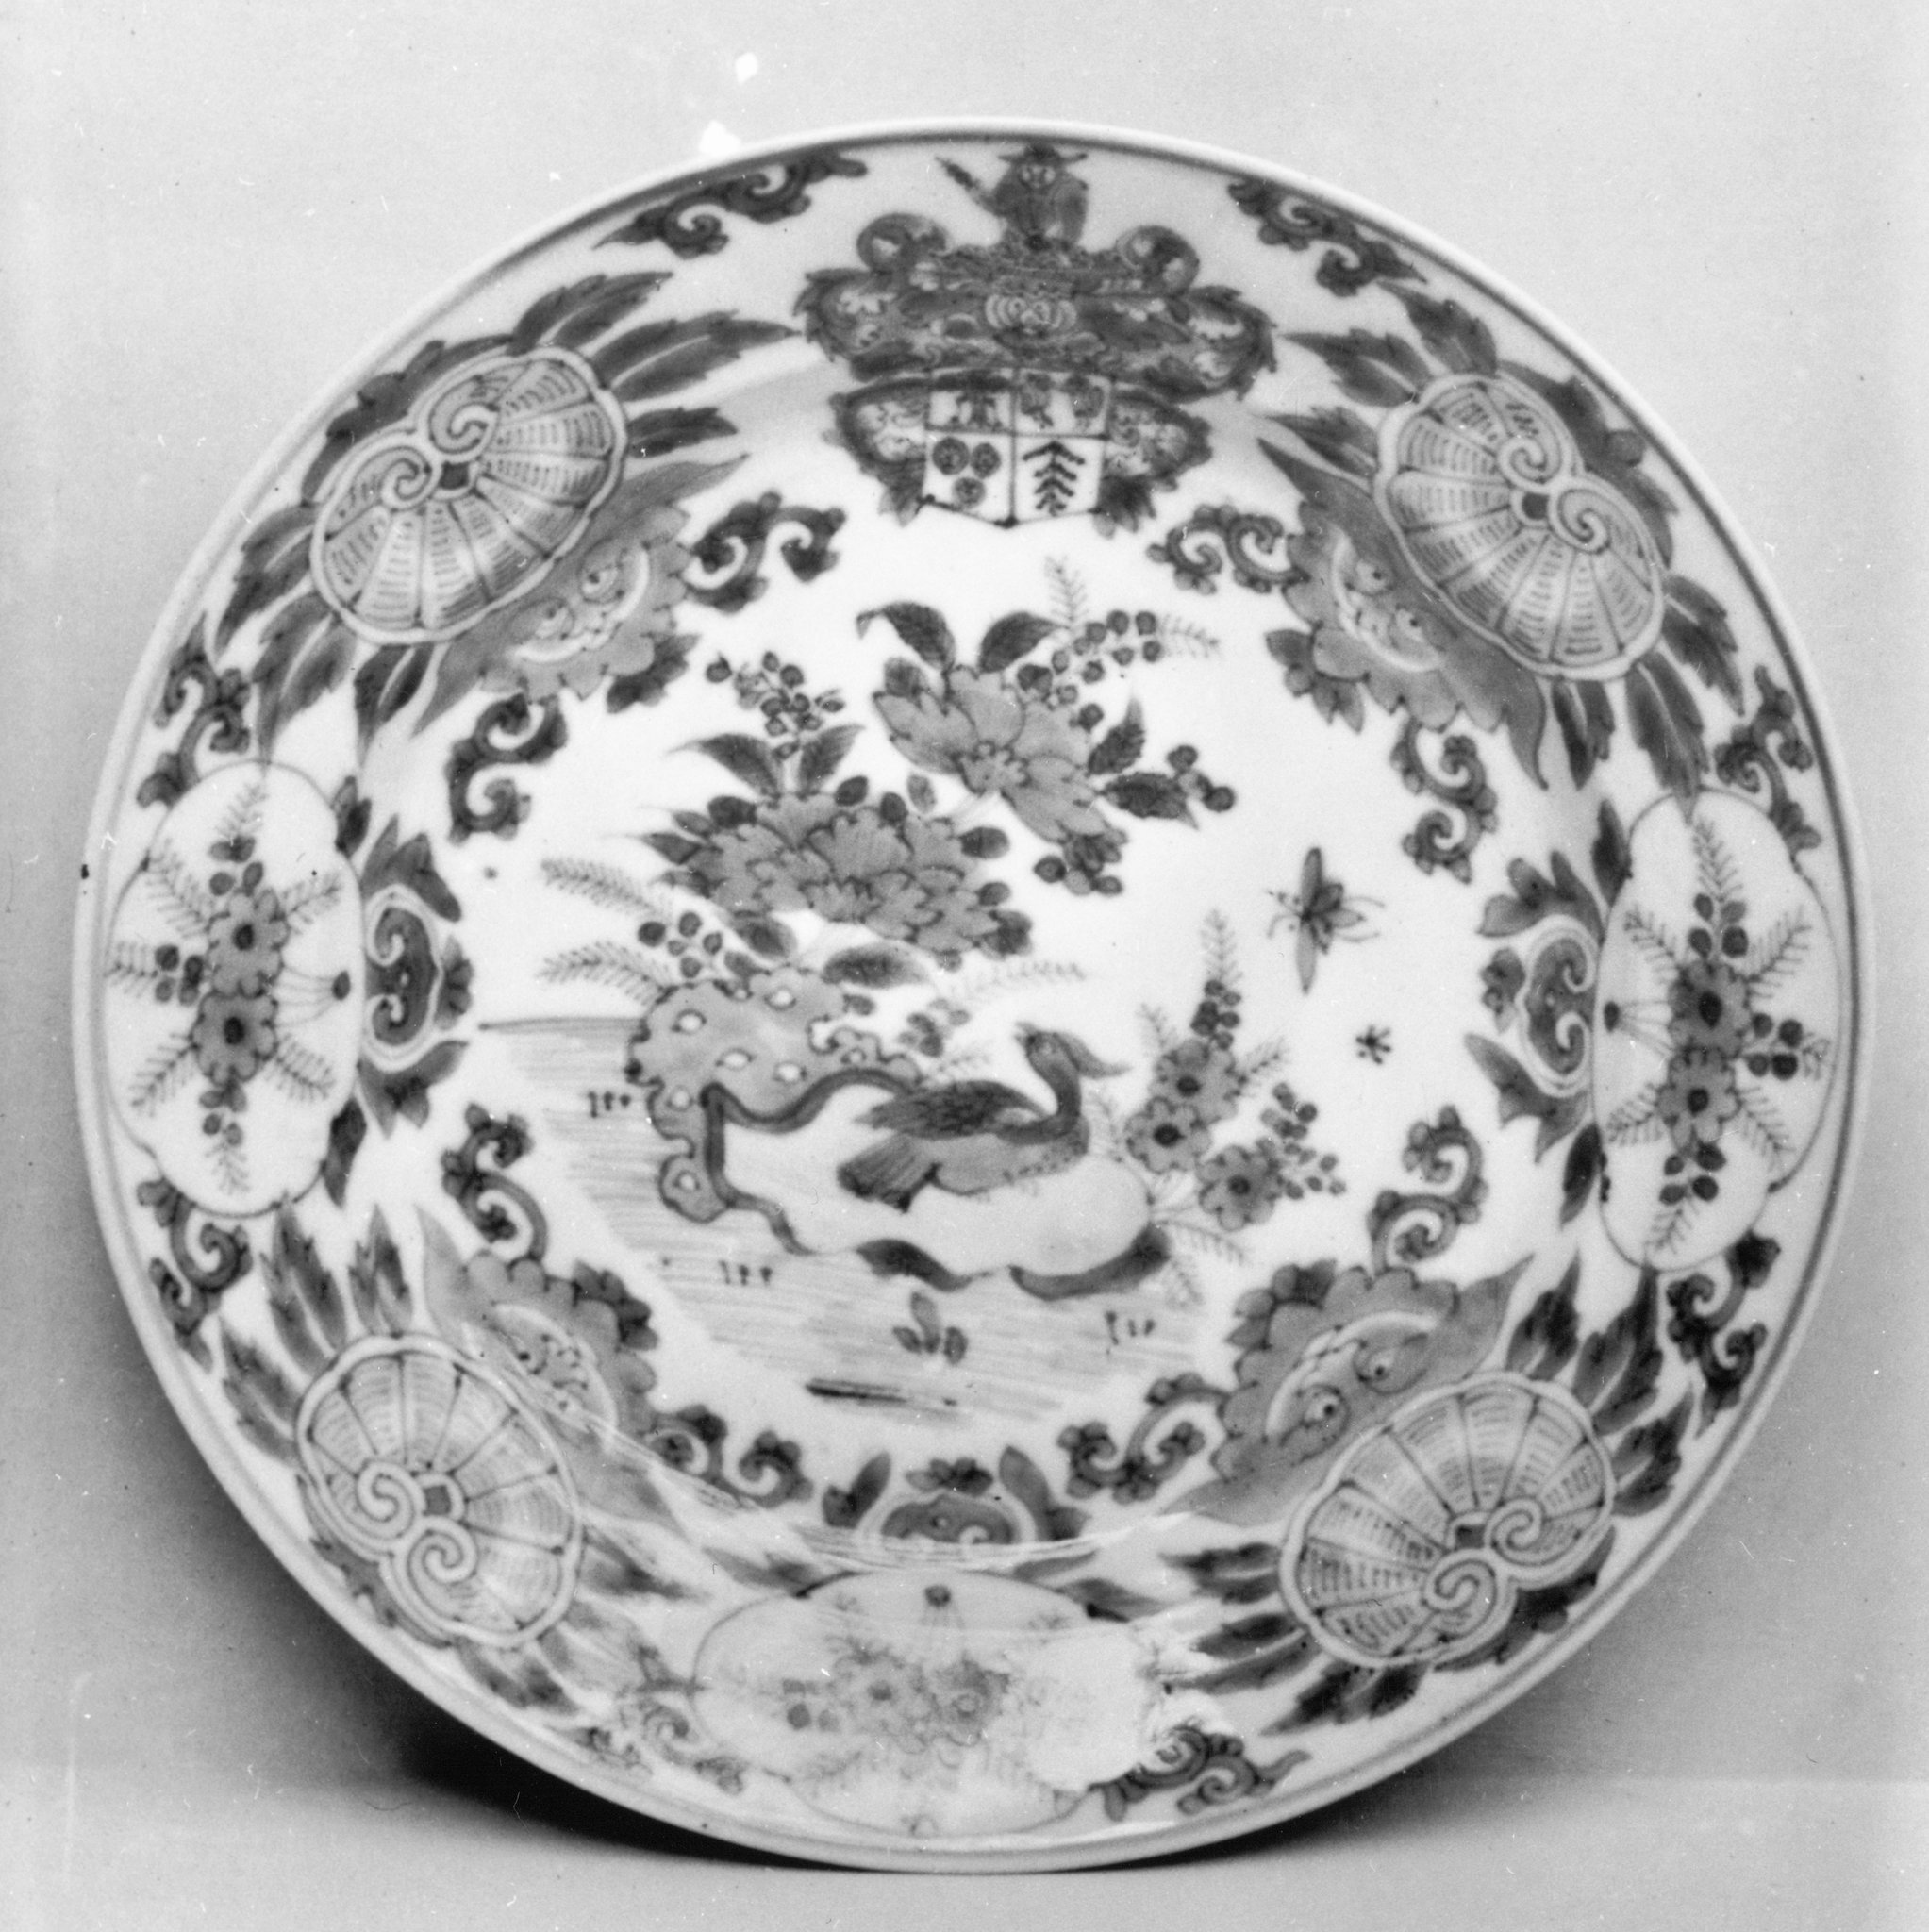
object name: plate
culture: chinese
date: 1662-1722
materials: porcelain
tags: birds,flowers,coat of arms